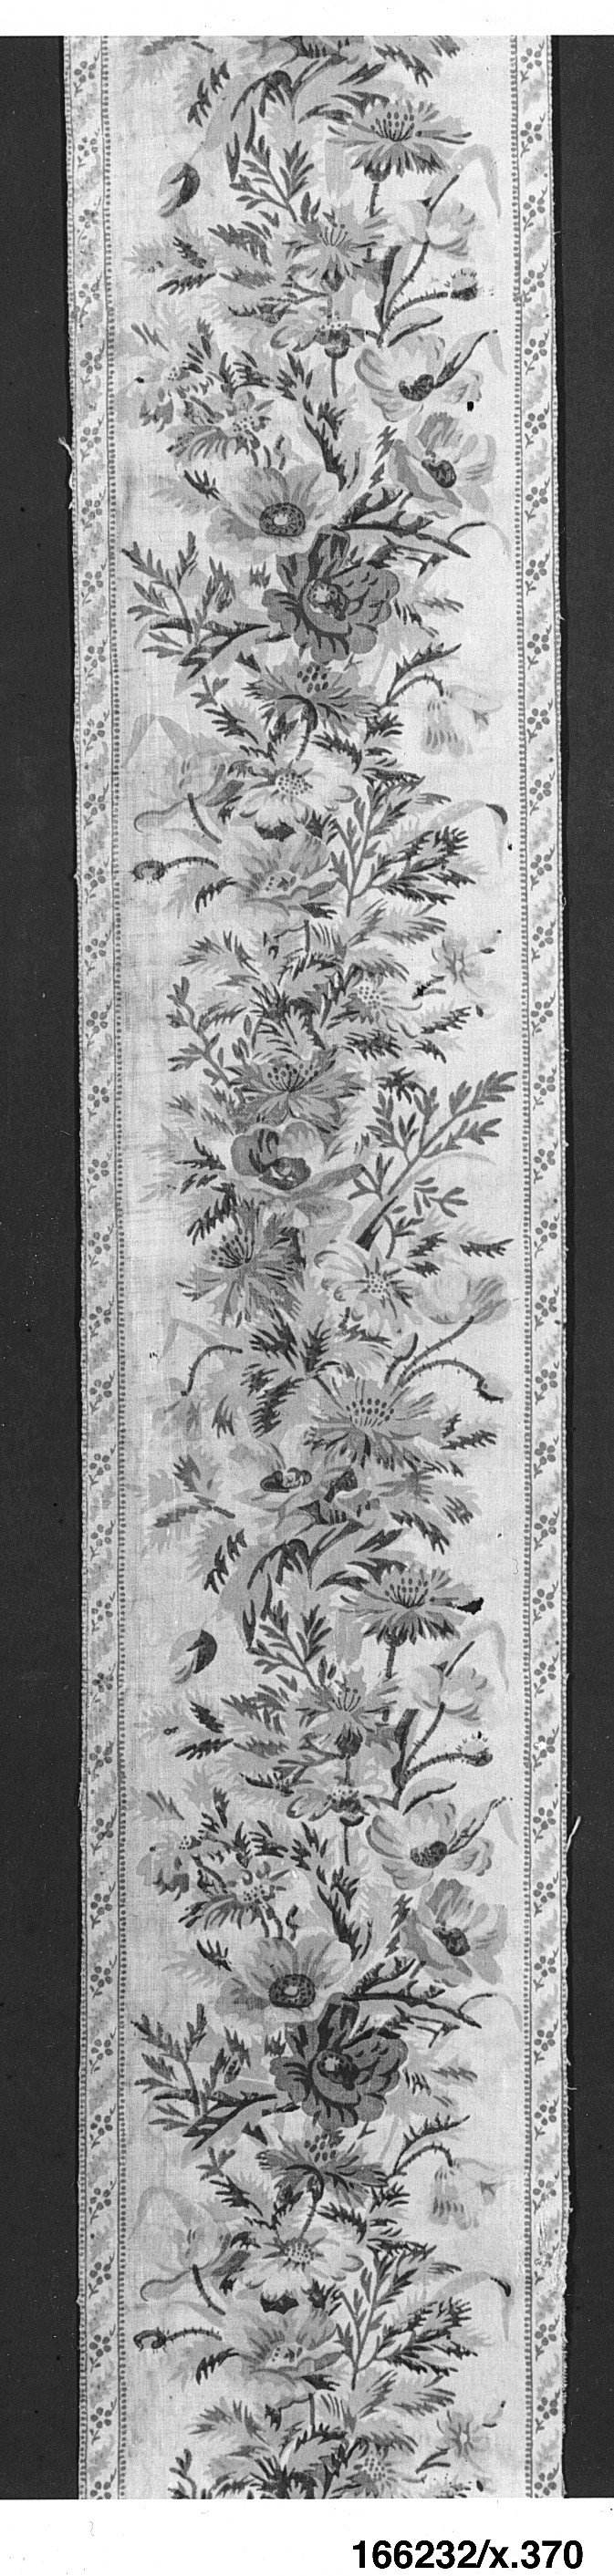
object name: border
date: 1830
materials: cotton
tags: flowers